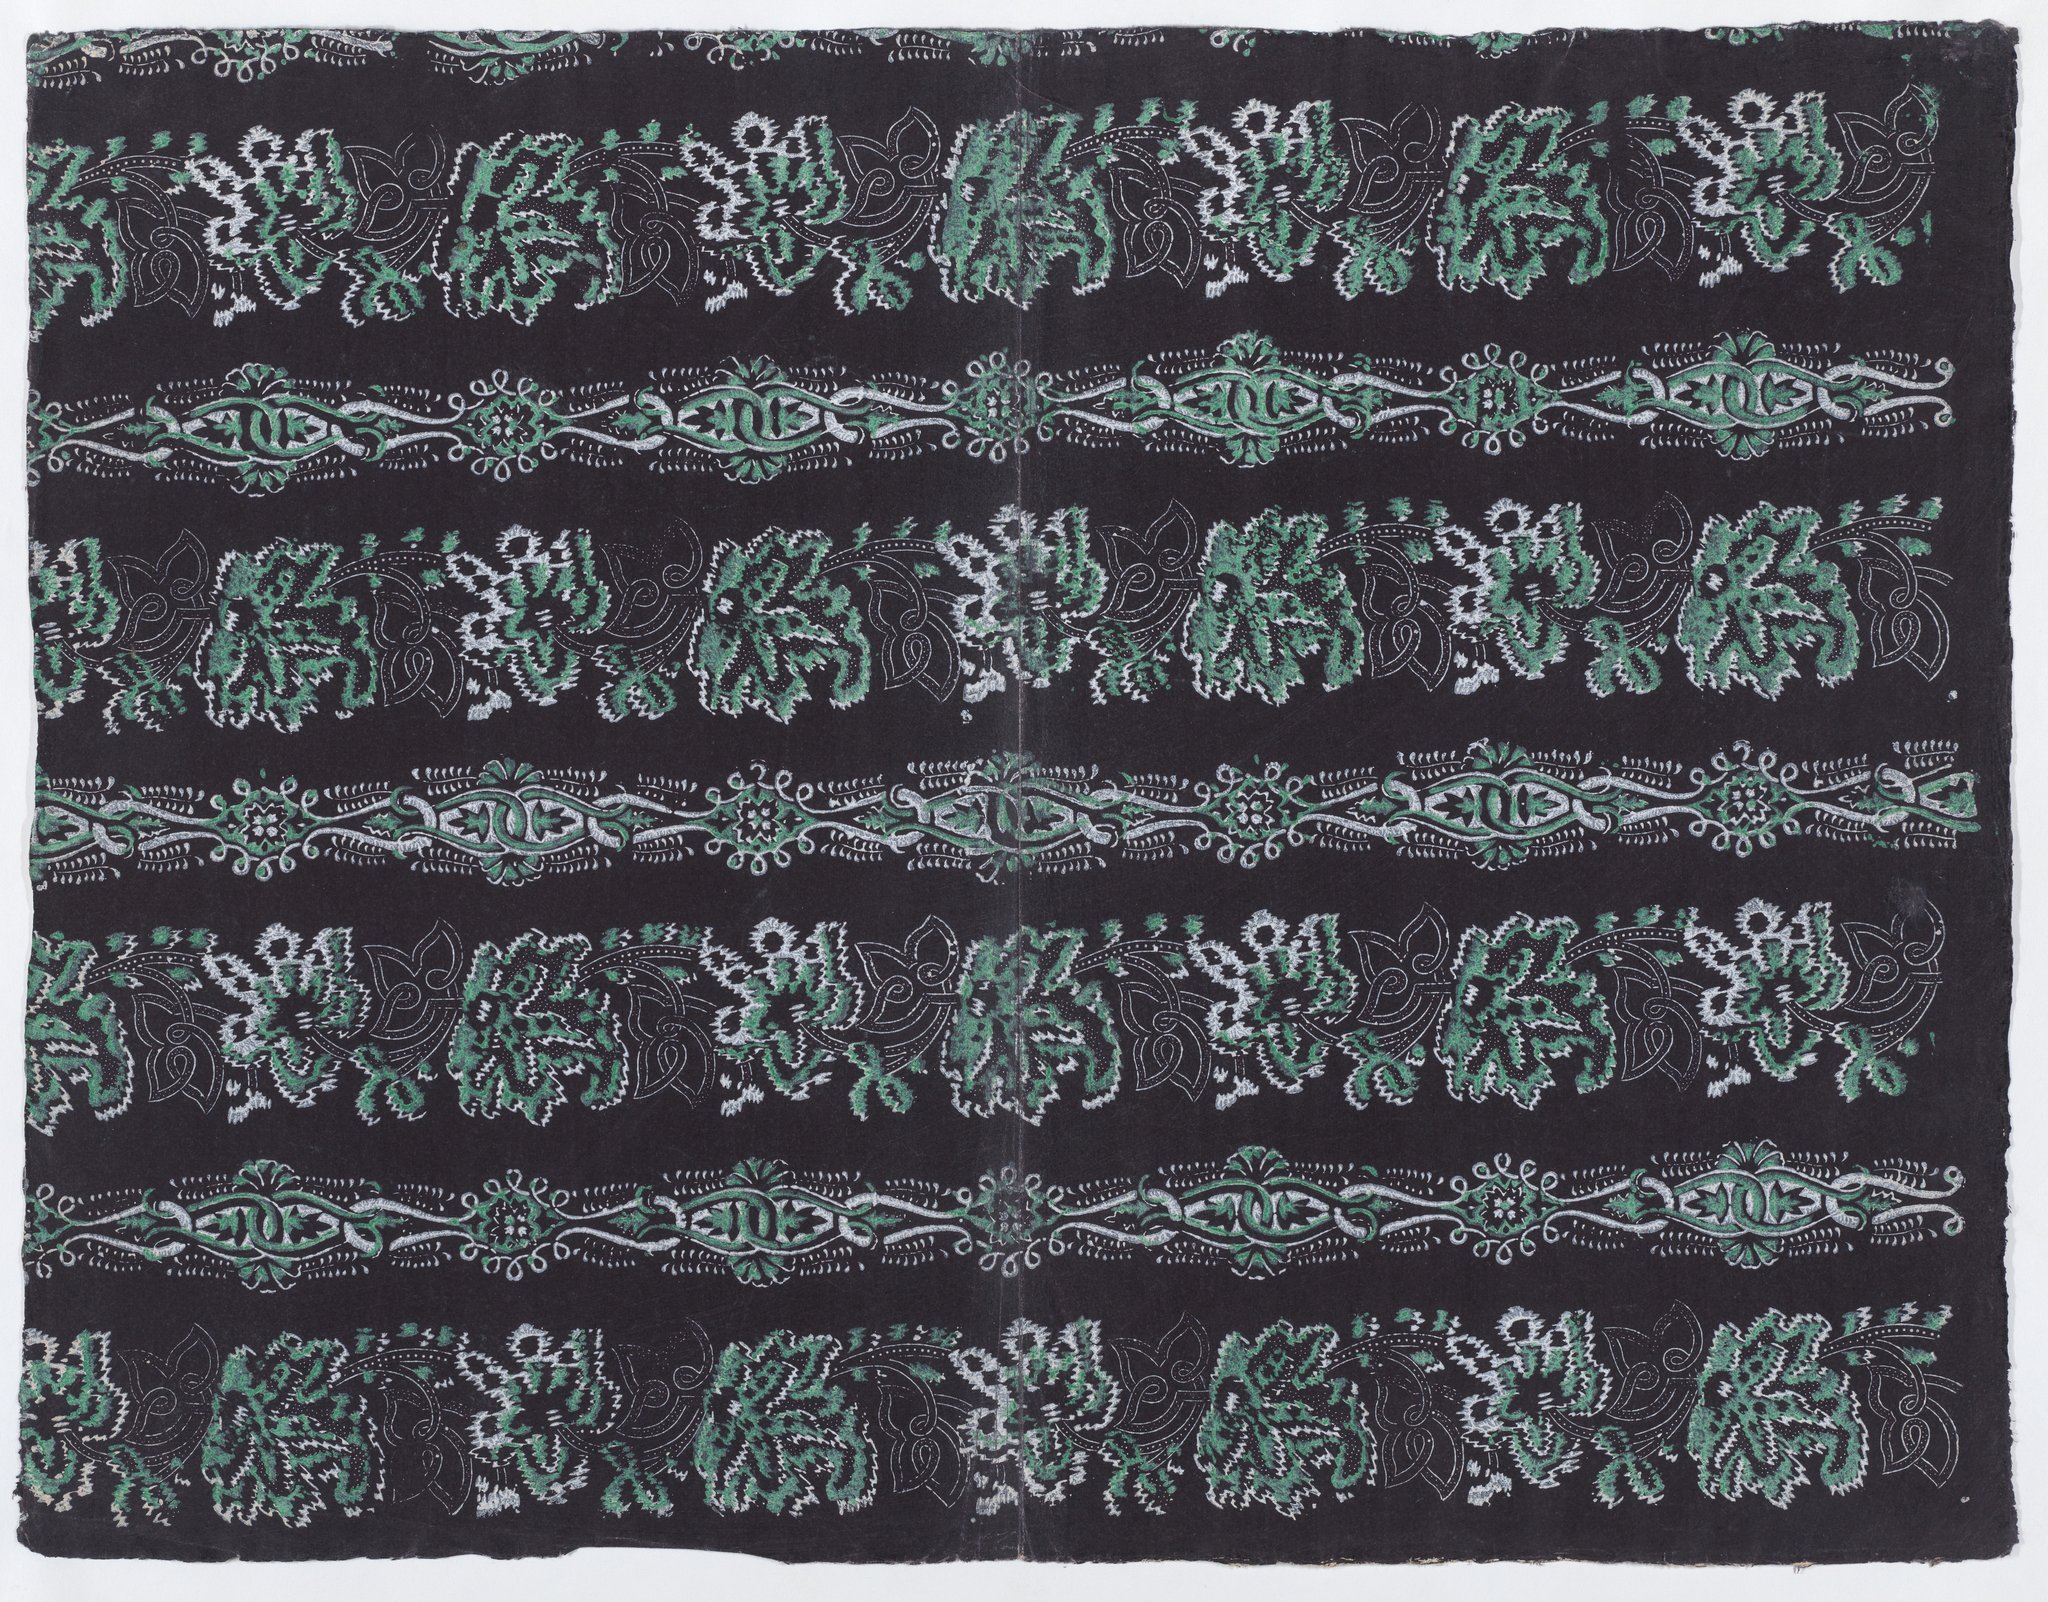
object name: print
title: Sheet with four borders with abstract patterns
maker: Anonymous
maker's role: artist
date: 1801-1900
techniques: relief print